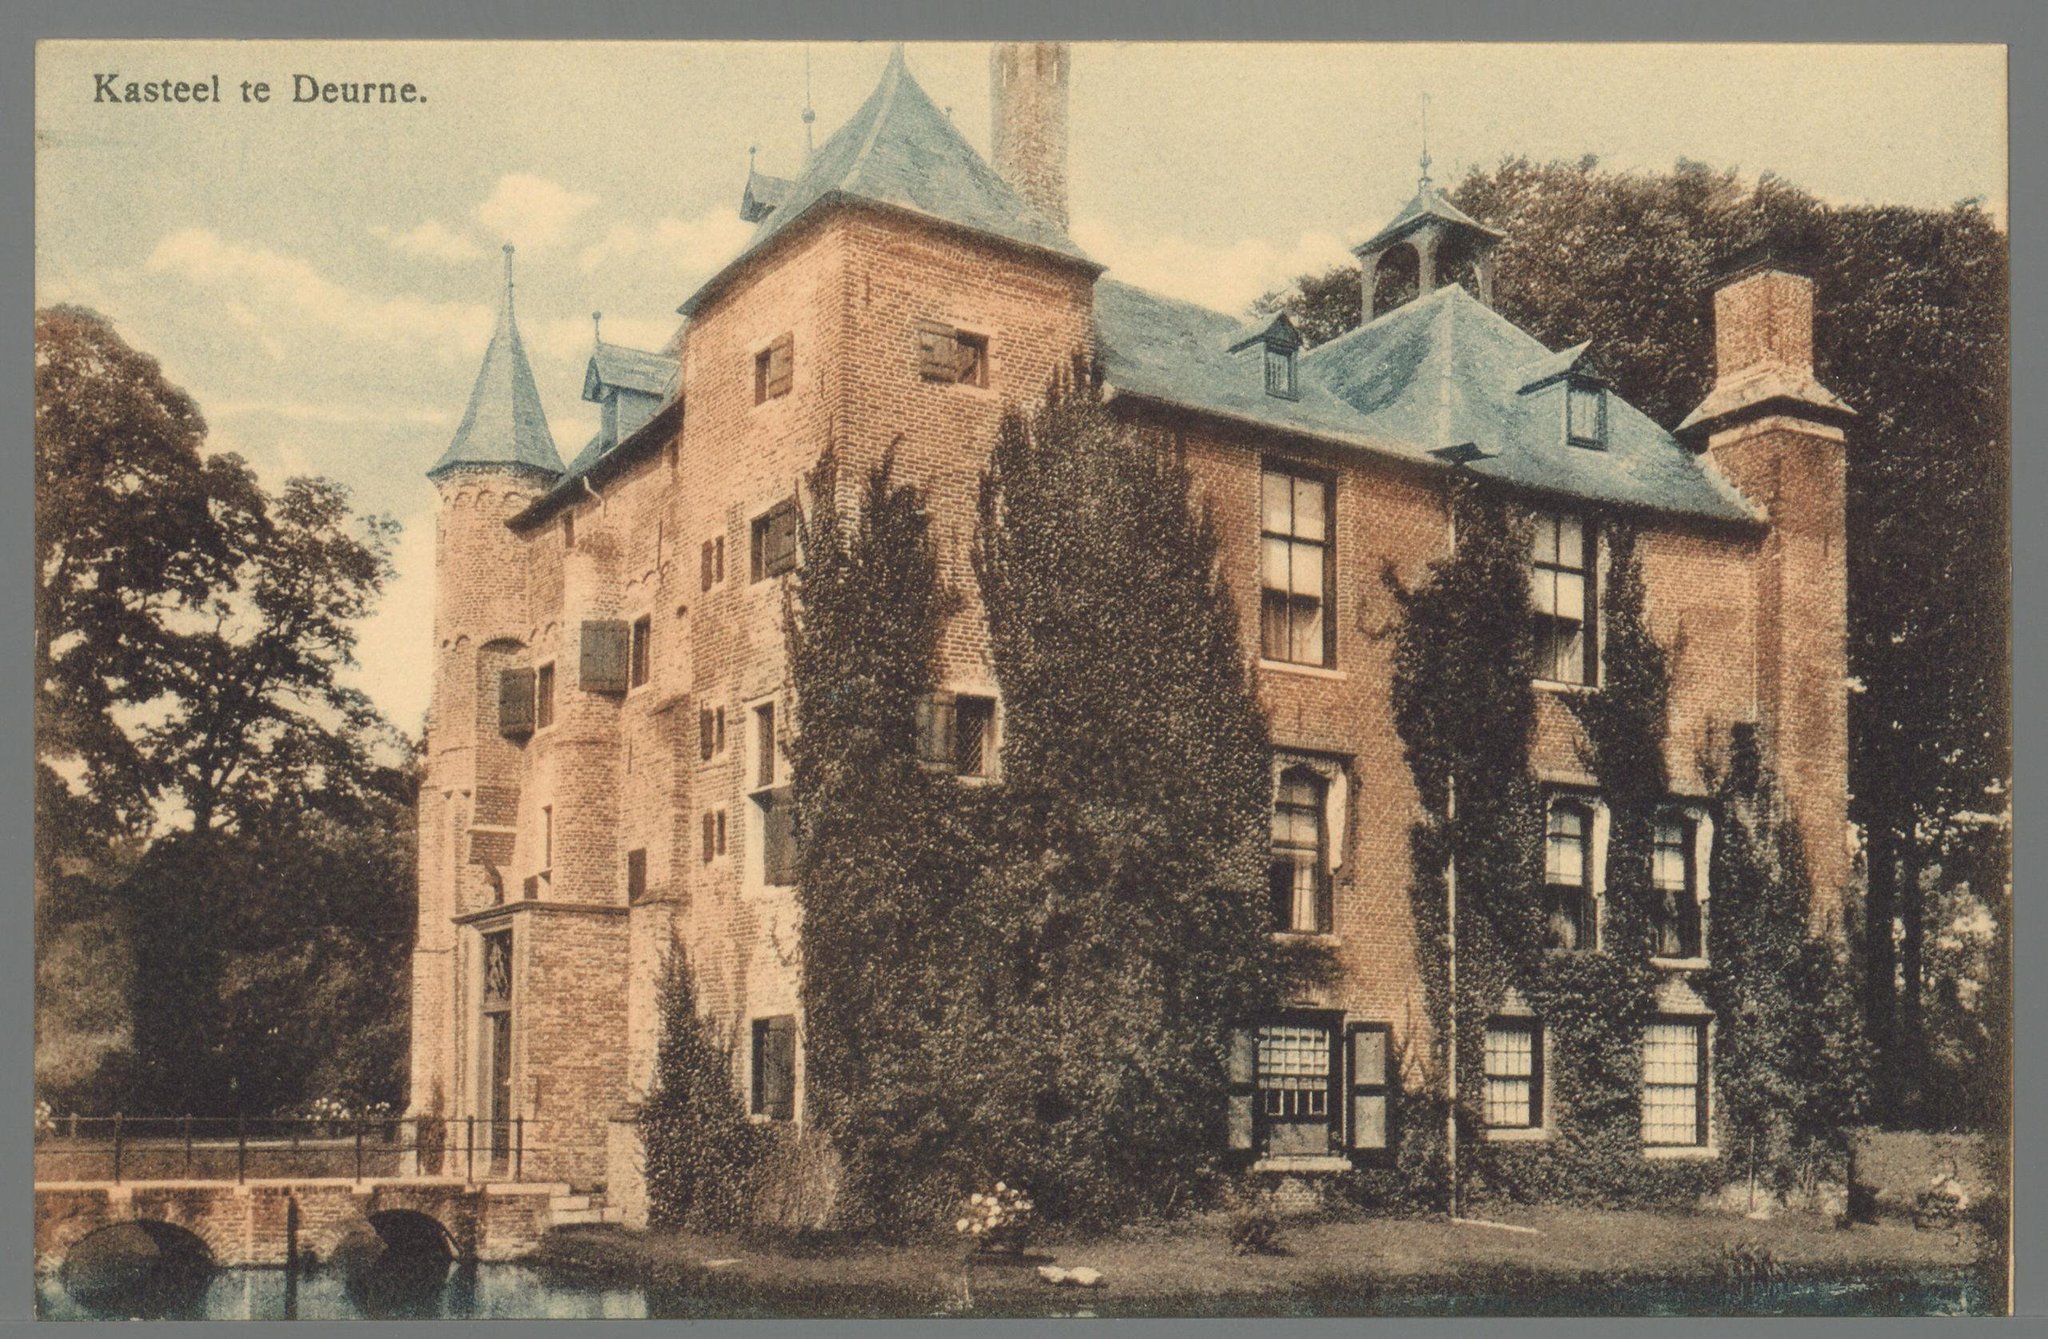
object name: ansichtkaart, prentbriefkaart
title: Kasteel te Deurne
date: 1905-1930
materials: cardboard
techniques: collotype process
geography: deurne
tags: castle